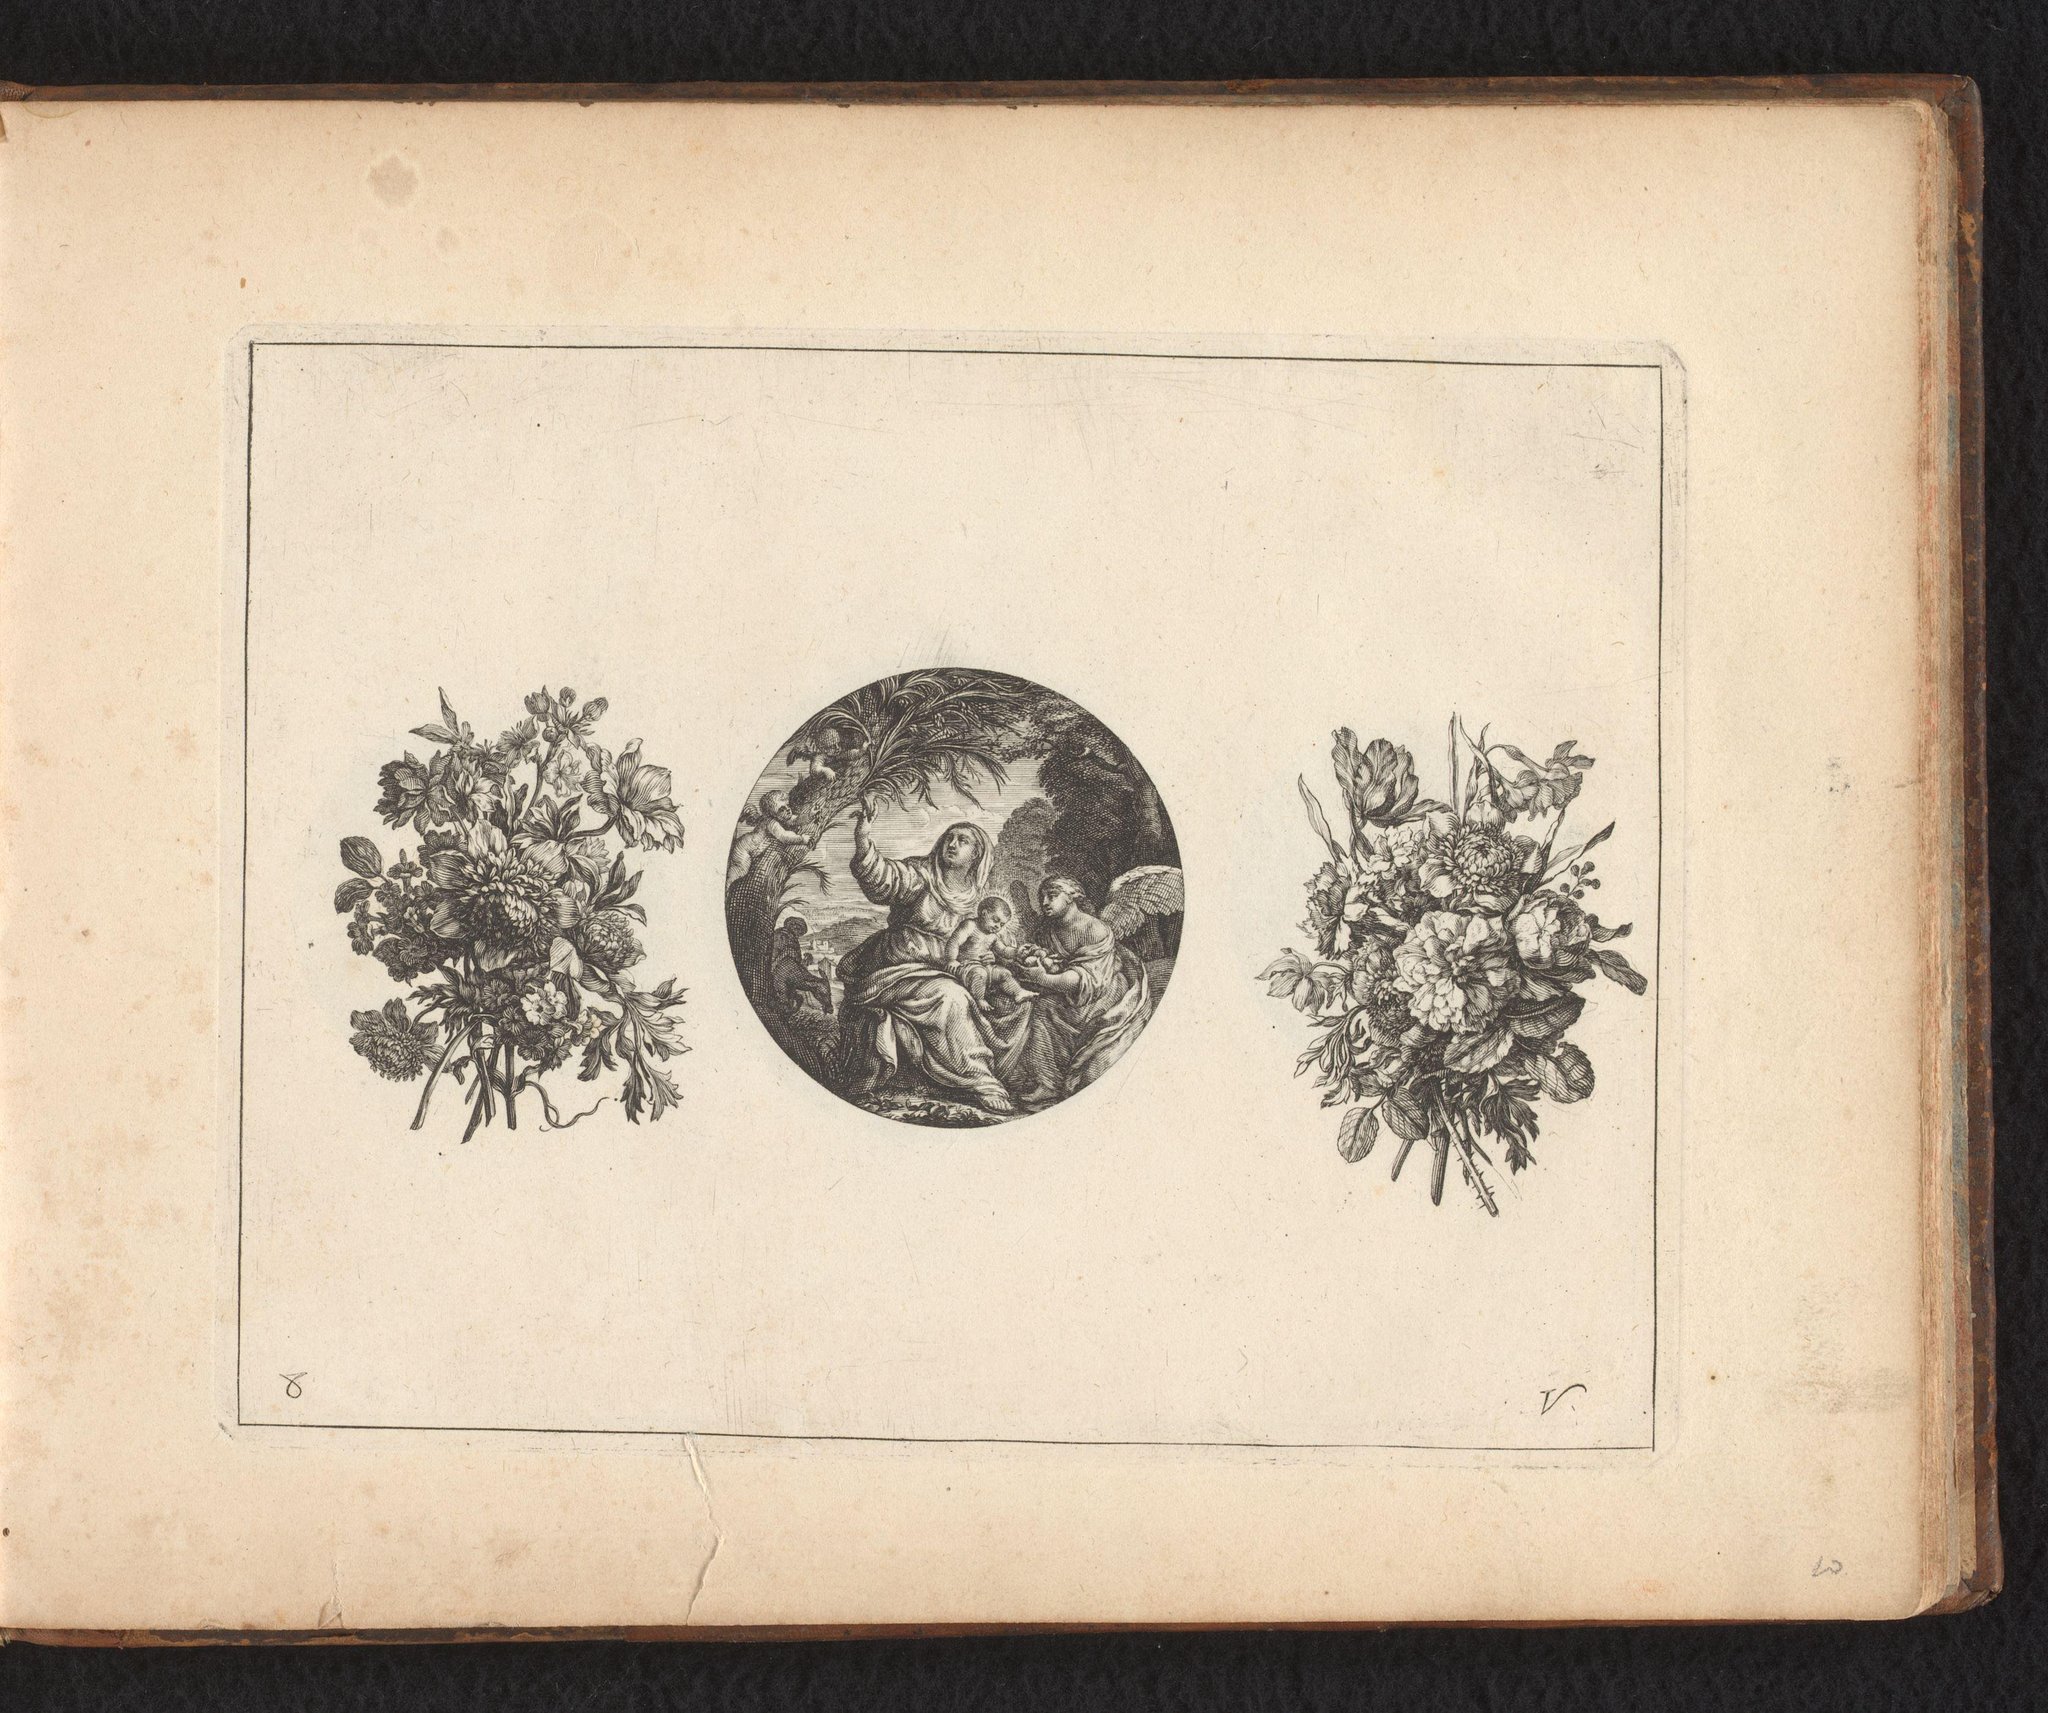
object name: print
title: Horlogekast met het wonder van de buigende palmboom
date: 1650-1676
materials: paper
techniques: engraving, etching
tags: miracle of the bending palmtree ~ rest on the flight into egypt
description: Rechts en links van de horlogekast een boeket. Deze prent maakt deel uit van een album.